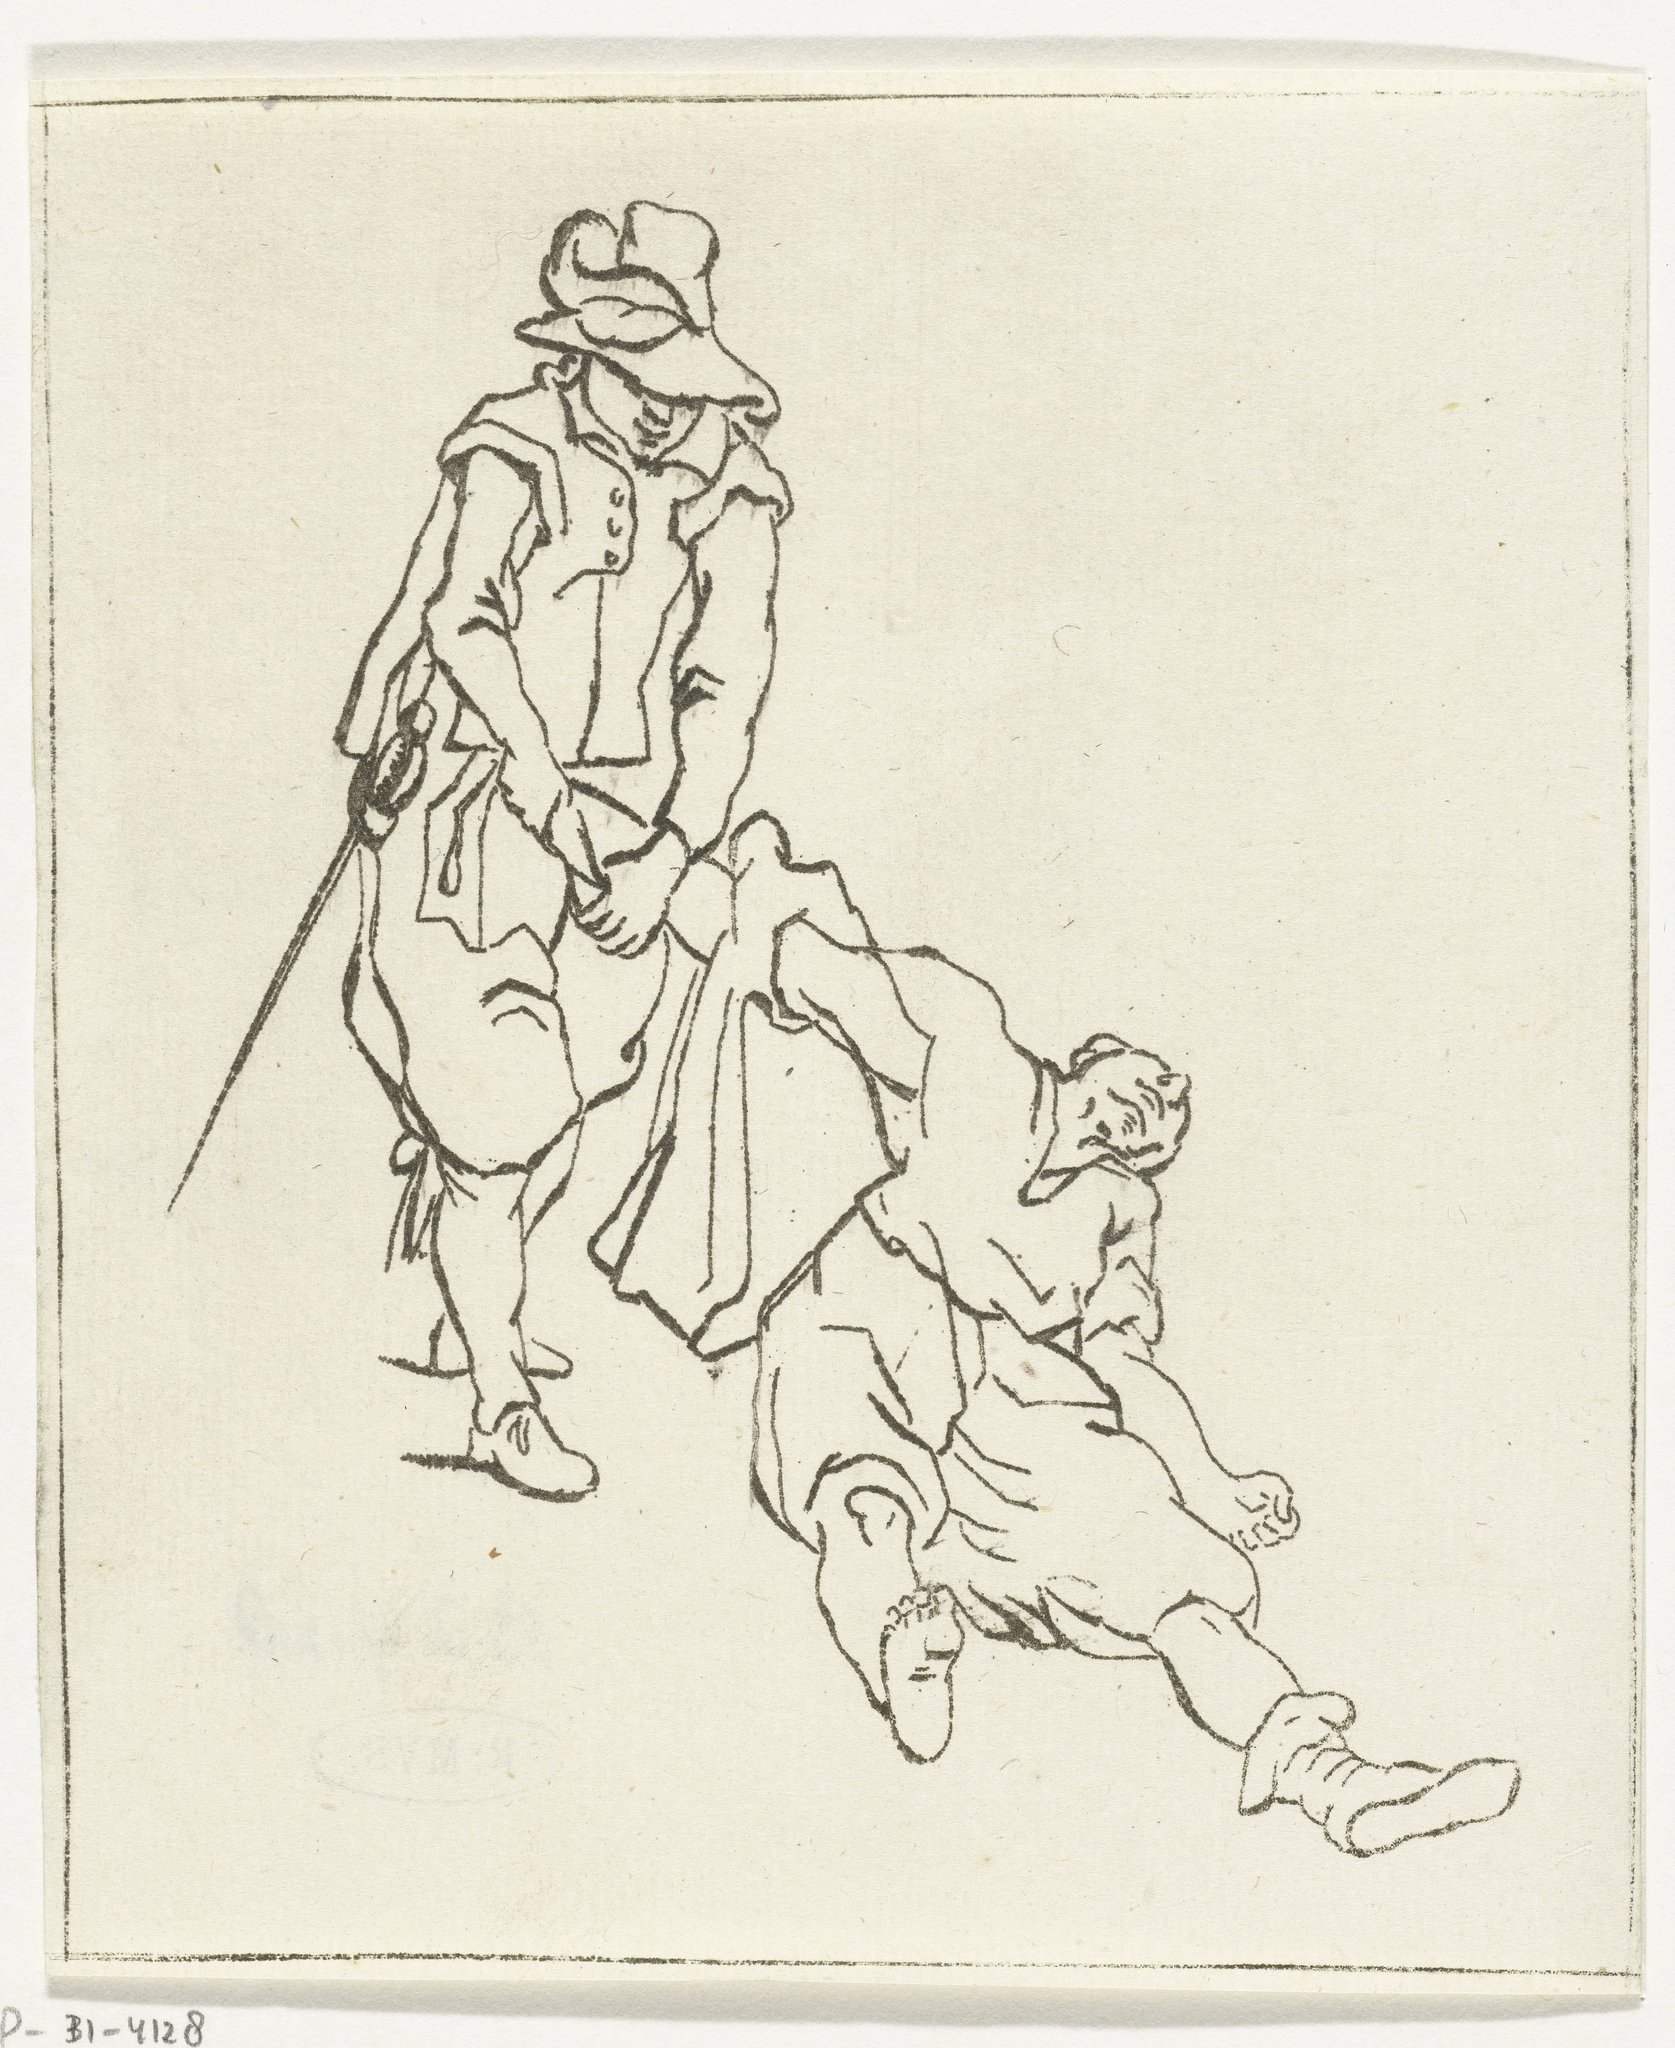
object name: print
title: Soldaat rooft kleed van gesneuvelde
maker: anthonie van den bos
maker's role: draughtsman, print maker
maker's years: 1763-1838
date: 1778-1838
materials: paper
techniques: printmaking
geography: netherlands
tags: despoiling corpse of its valuables or vestments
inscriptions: collector's mark: Lugt 2228